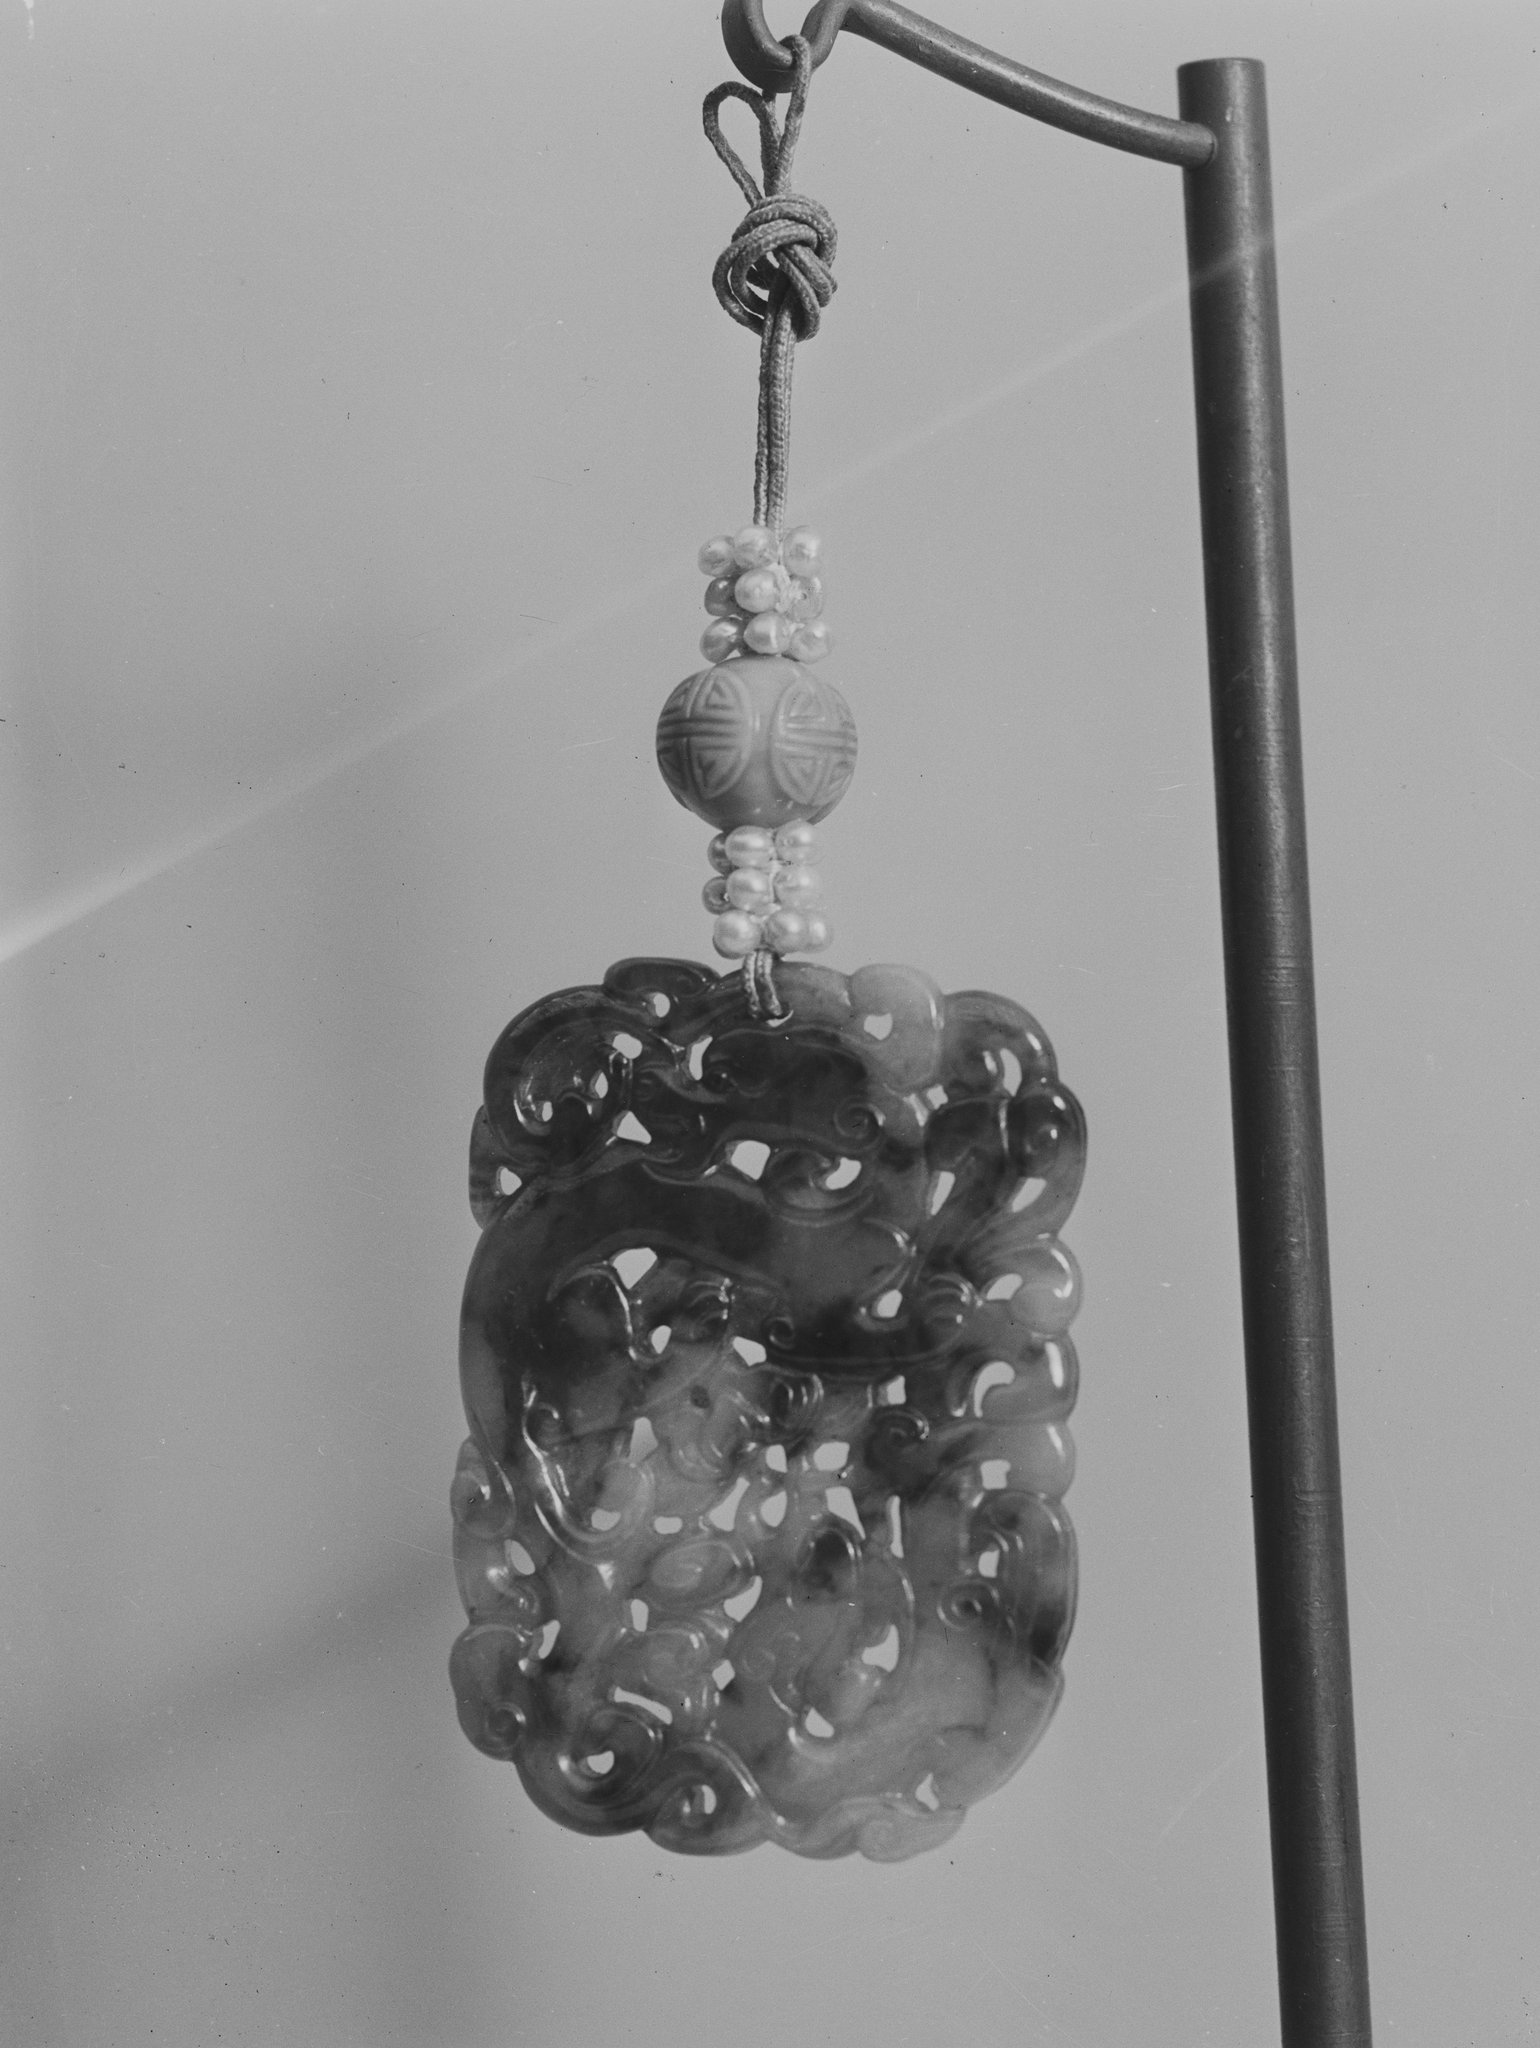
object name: pendant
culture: chinese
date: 1644-1911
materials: jade